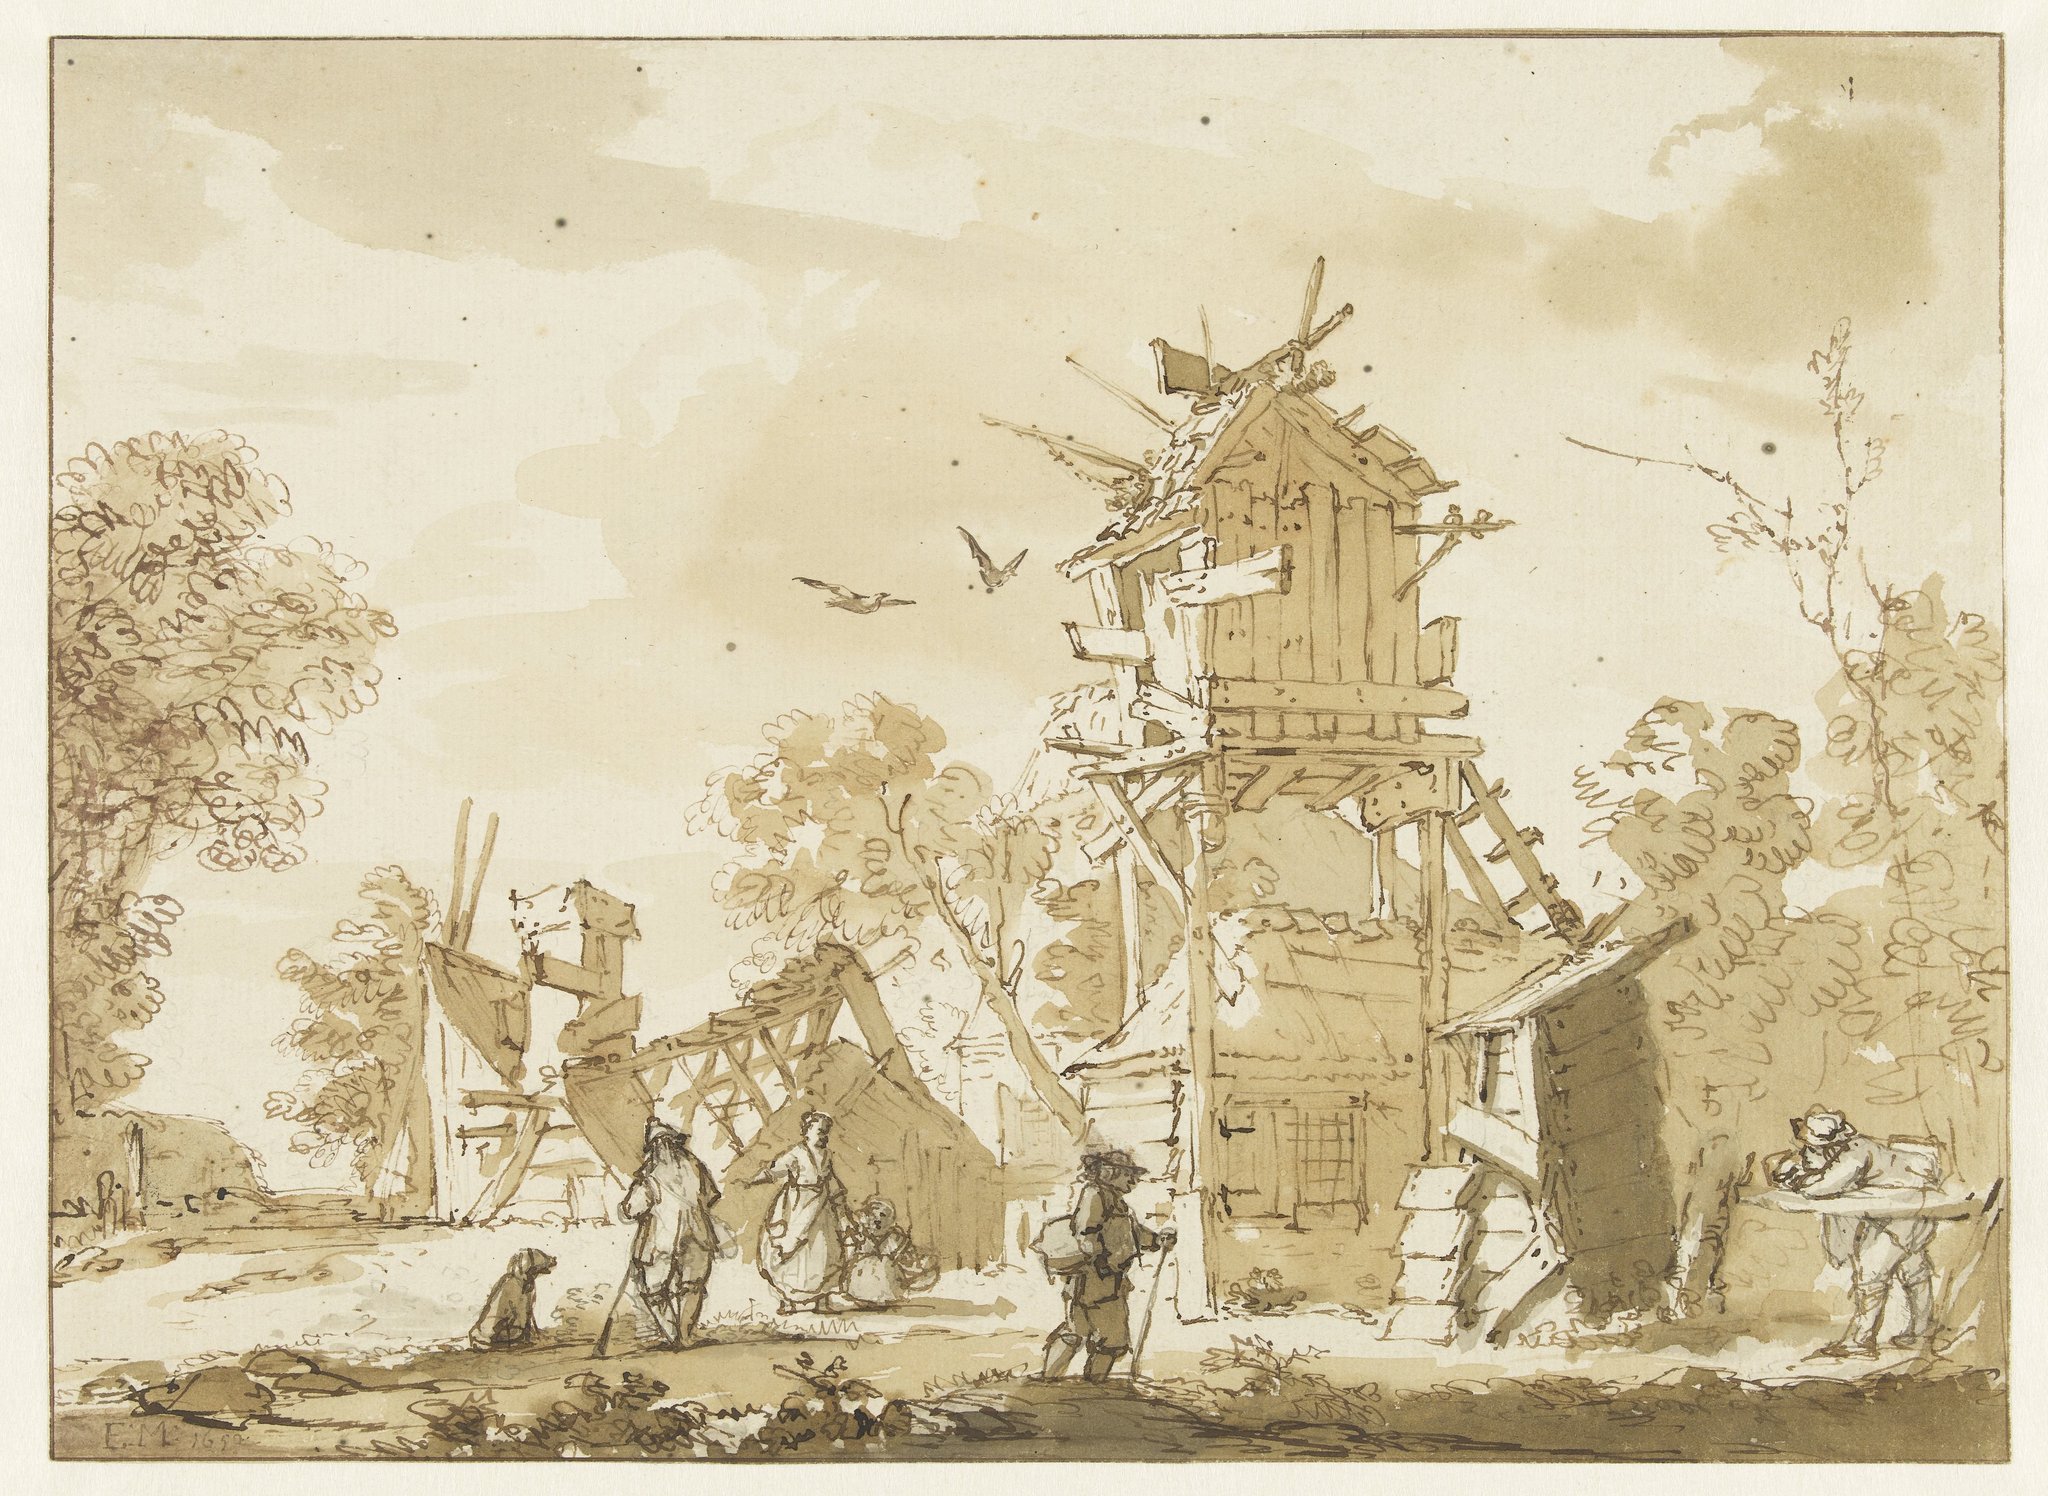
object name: drawing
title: Figuren bij een vervallen boerderij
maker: bartholomeus barbiers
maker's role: draughtsman, painter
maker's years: 1740-1808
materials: graphite, ink, paper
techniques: brush, pen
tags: farm or solitary house in landscape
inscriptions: monogram and date: ‘Ë.M. 1652’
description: Een variant hierop bevindt zich in het Teylers Museum, inv. KT 1996:75 (Cat. L. Schwartz, nr. 5).